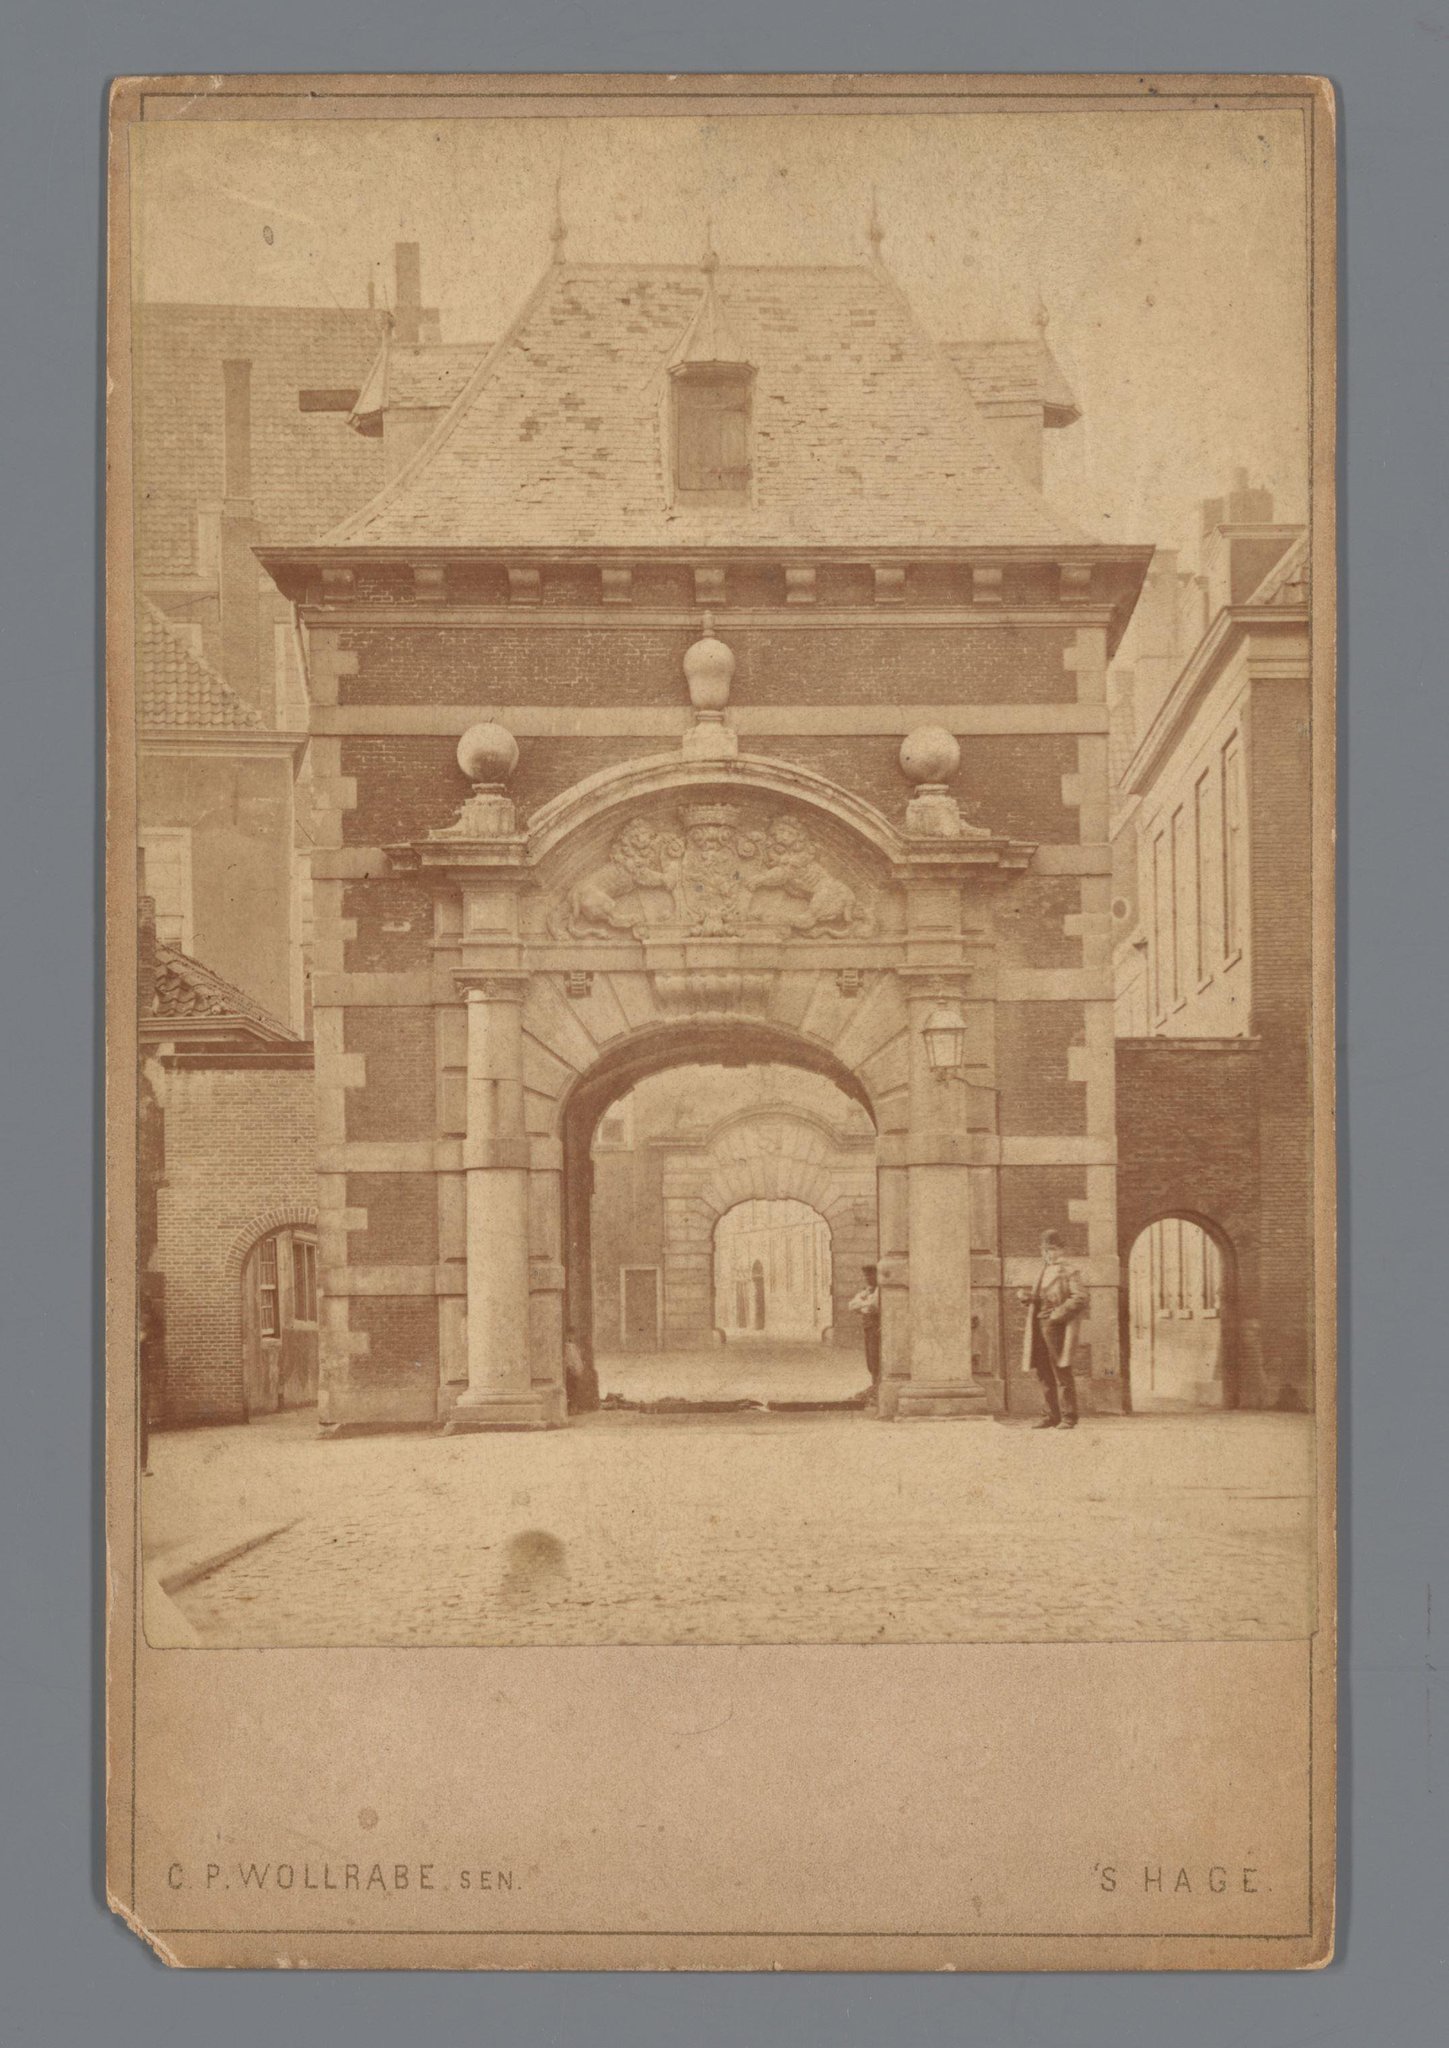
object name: photograph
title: Gezicht op de Mauritspoort op het Binnenhof te Den Haag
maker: carl philip wollrabe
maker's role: fotograaf, musicus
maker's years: 1812-1887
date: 1860-1875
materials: cardboard, photographic support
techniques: albumen print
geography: the hague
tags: gate, entrance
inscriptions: inscription: ‘C.P. Wollrabe sen./ 's Hage’, inscription: ‘C.P. Wollrabe sen./ Photographe (...) 91 Boekhorststraat 91/ 's Hage’